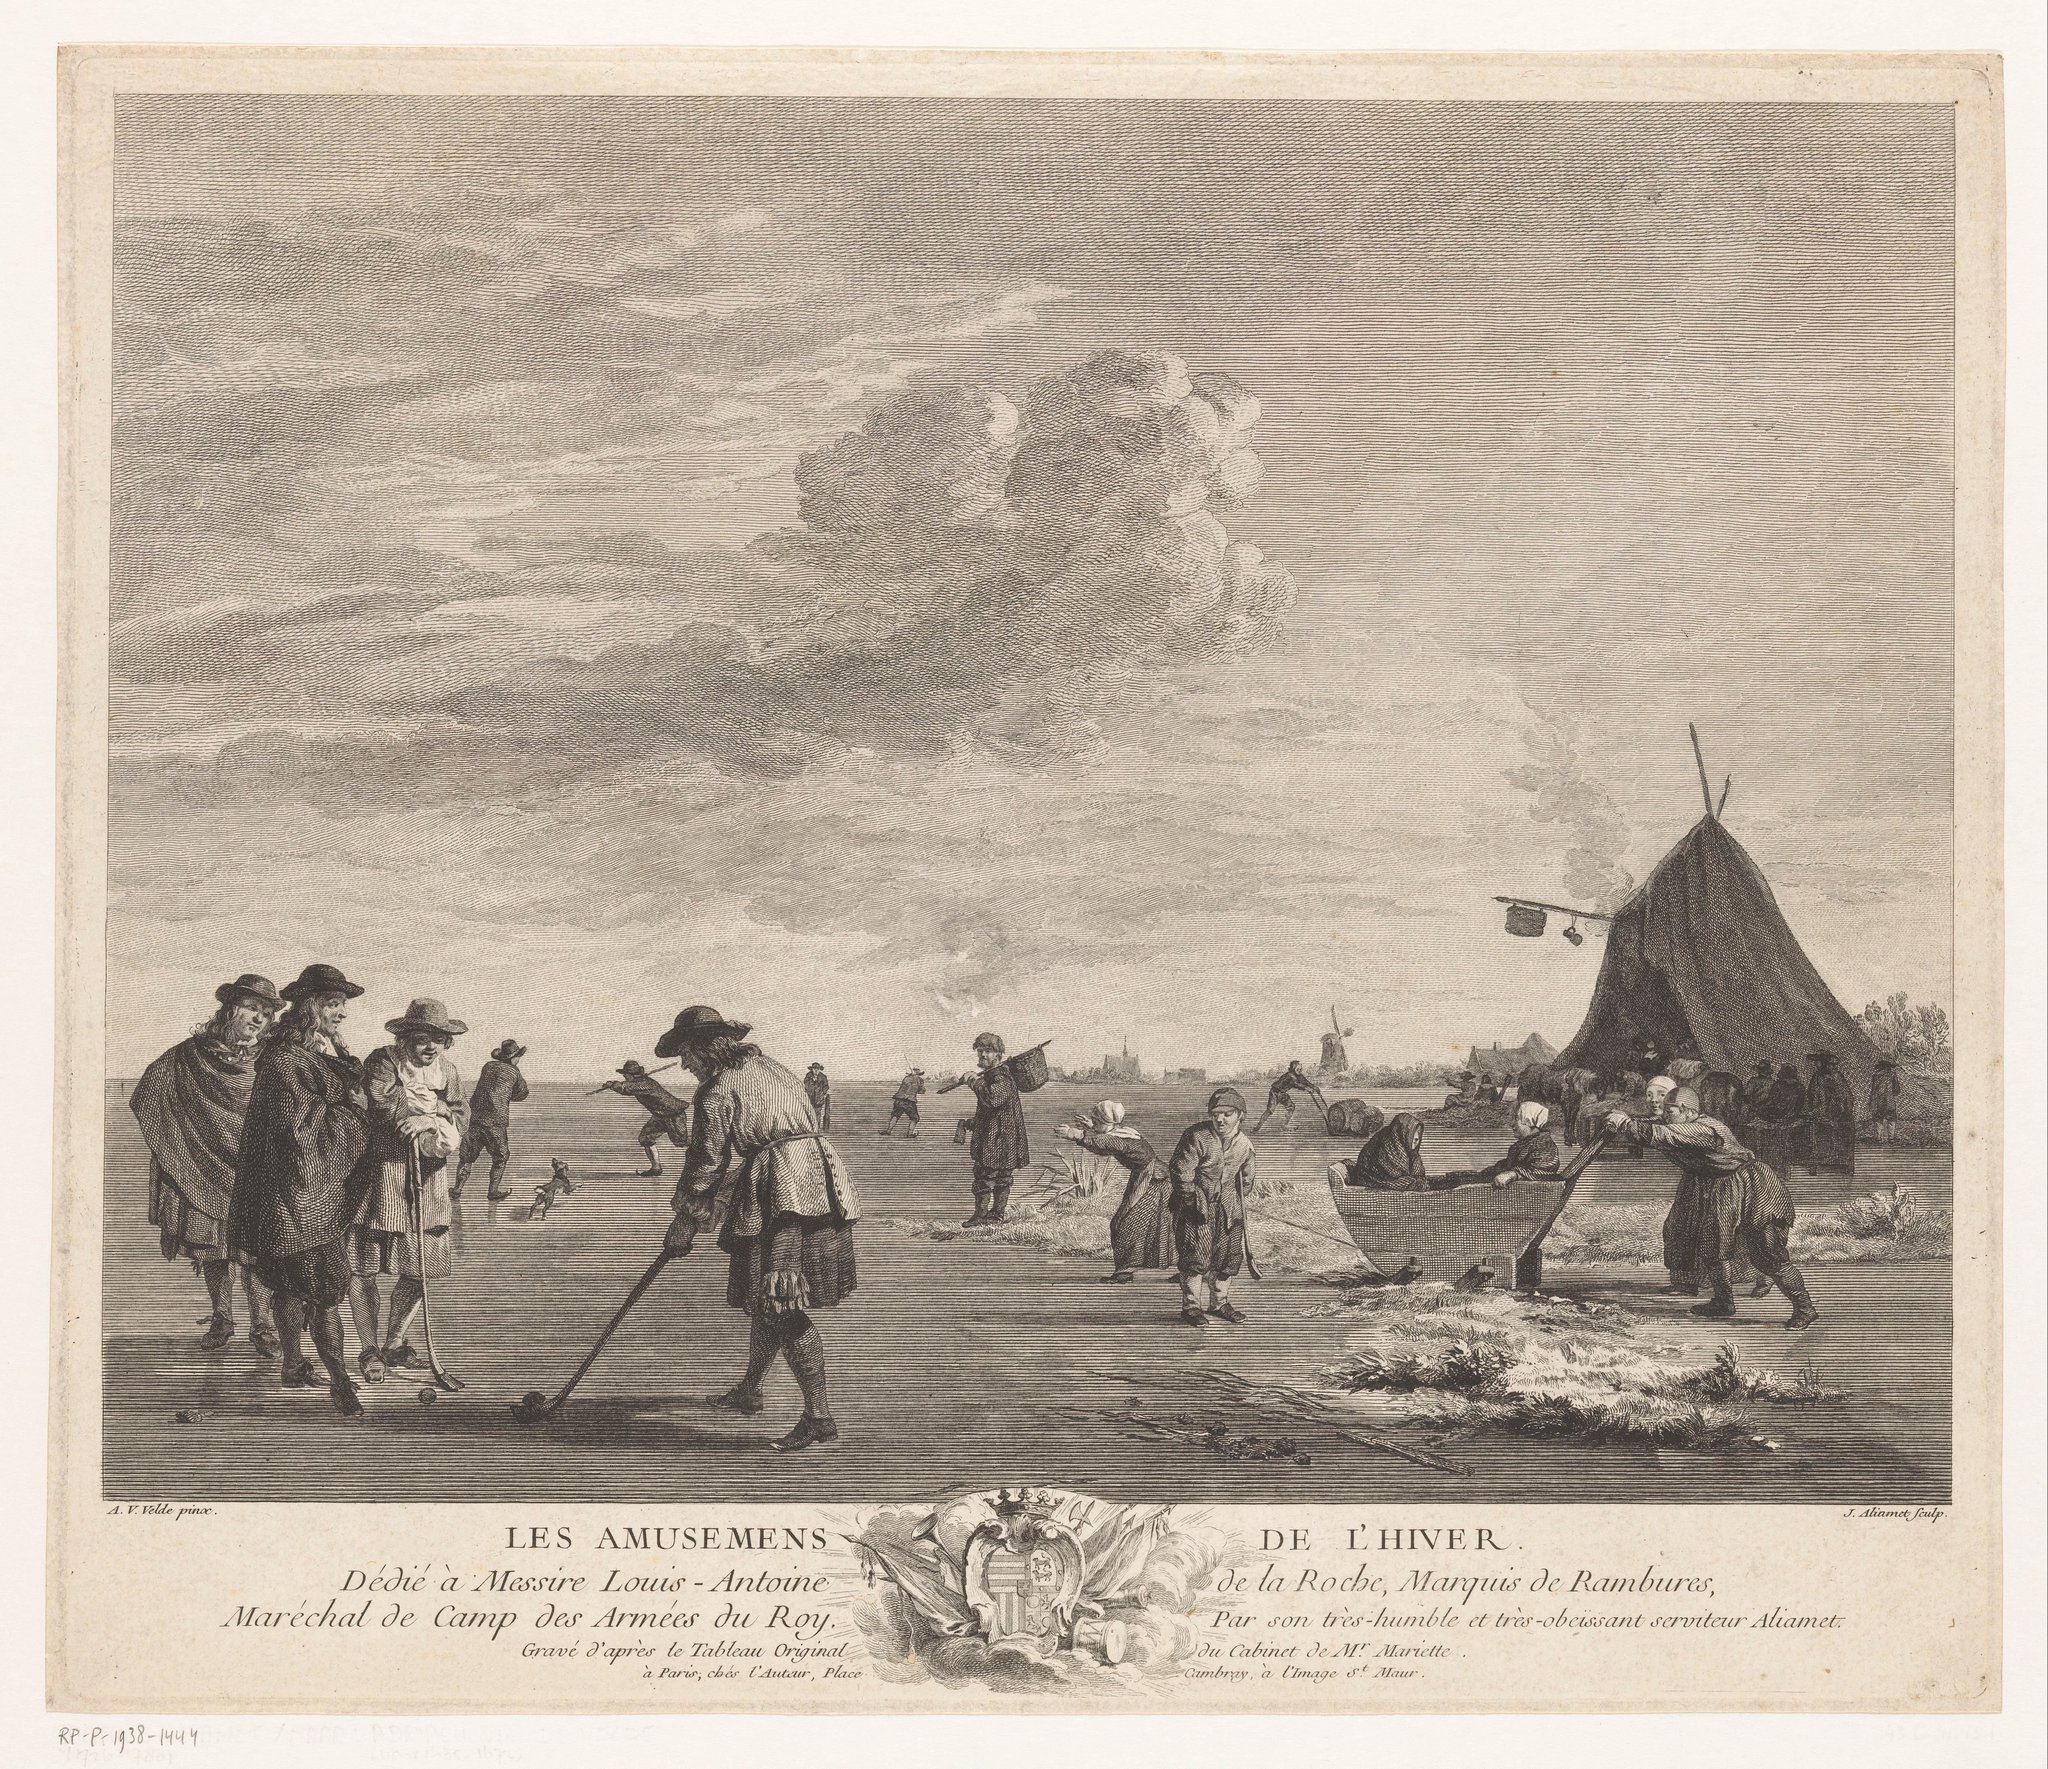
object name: print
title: Les amusemens de l'hiver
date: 1750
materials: paper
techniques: engraving, etching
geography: france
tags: ice ~ freezing weather, winter landscape; landscape symbolizing winter (the four seasons of the year), 'kolf' on the ice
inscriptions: collector's mark: Lugt 2228